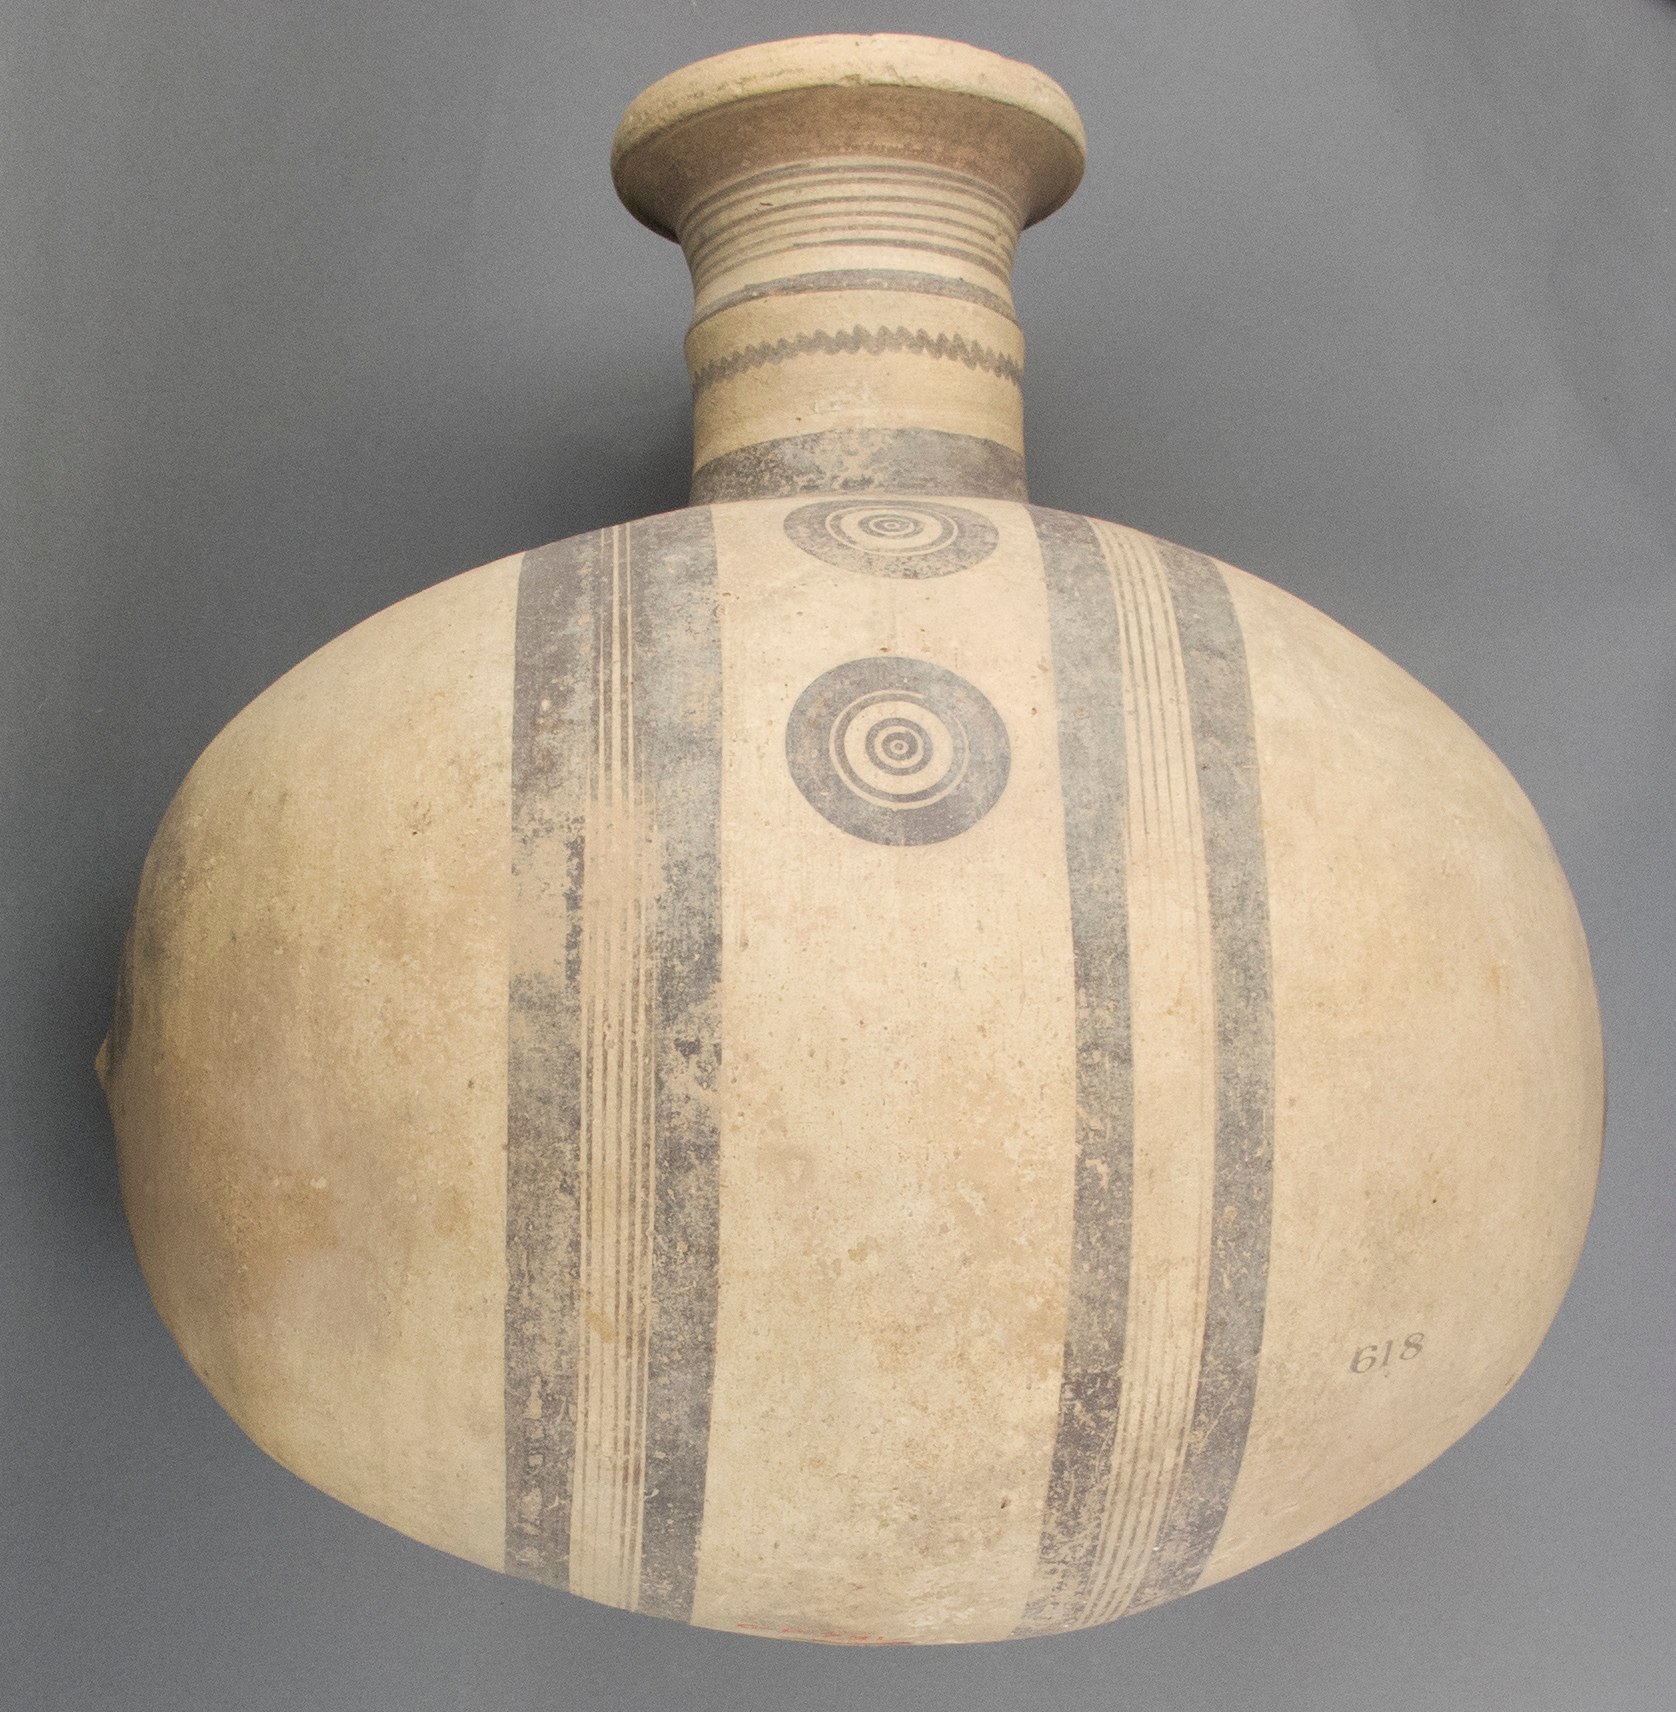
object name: jug, barrel shaped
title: Jug, barrel-shaped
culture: cypriot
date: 750-600 BCE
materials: terracotta